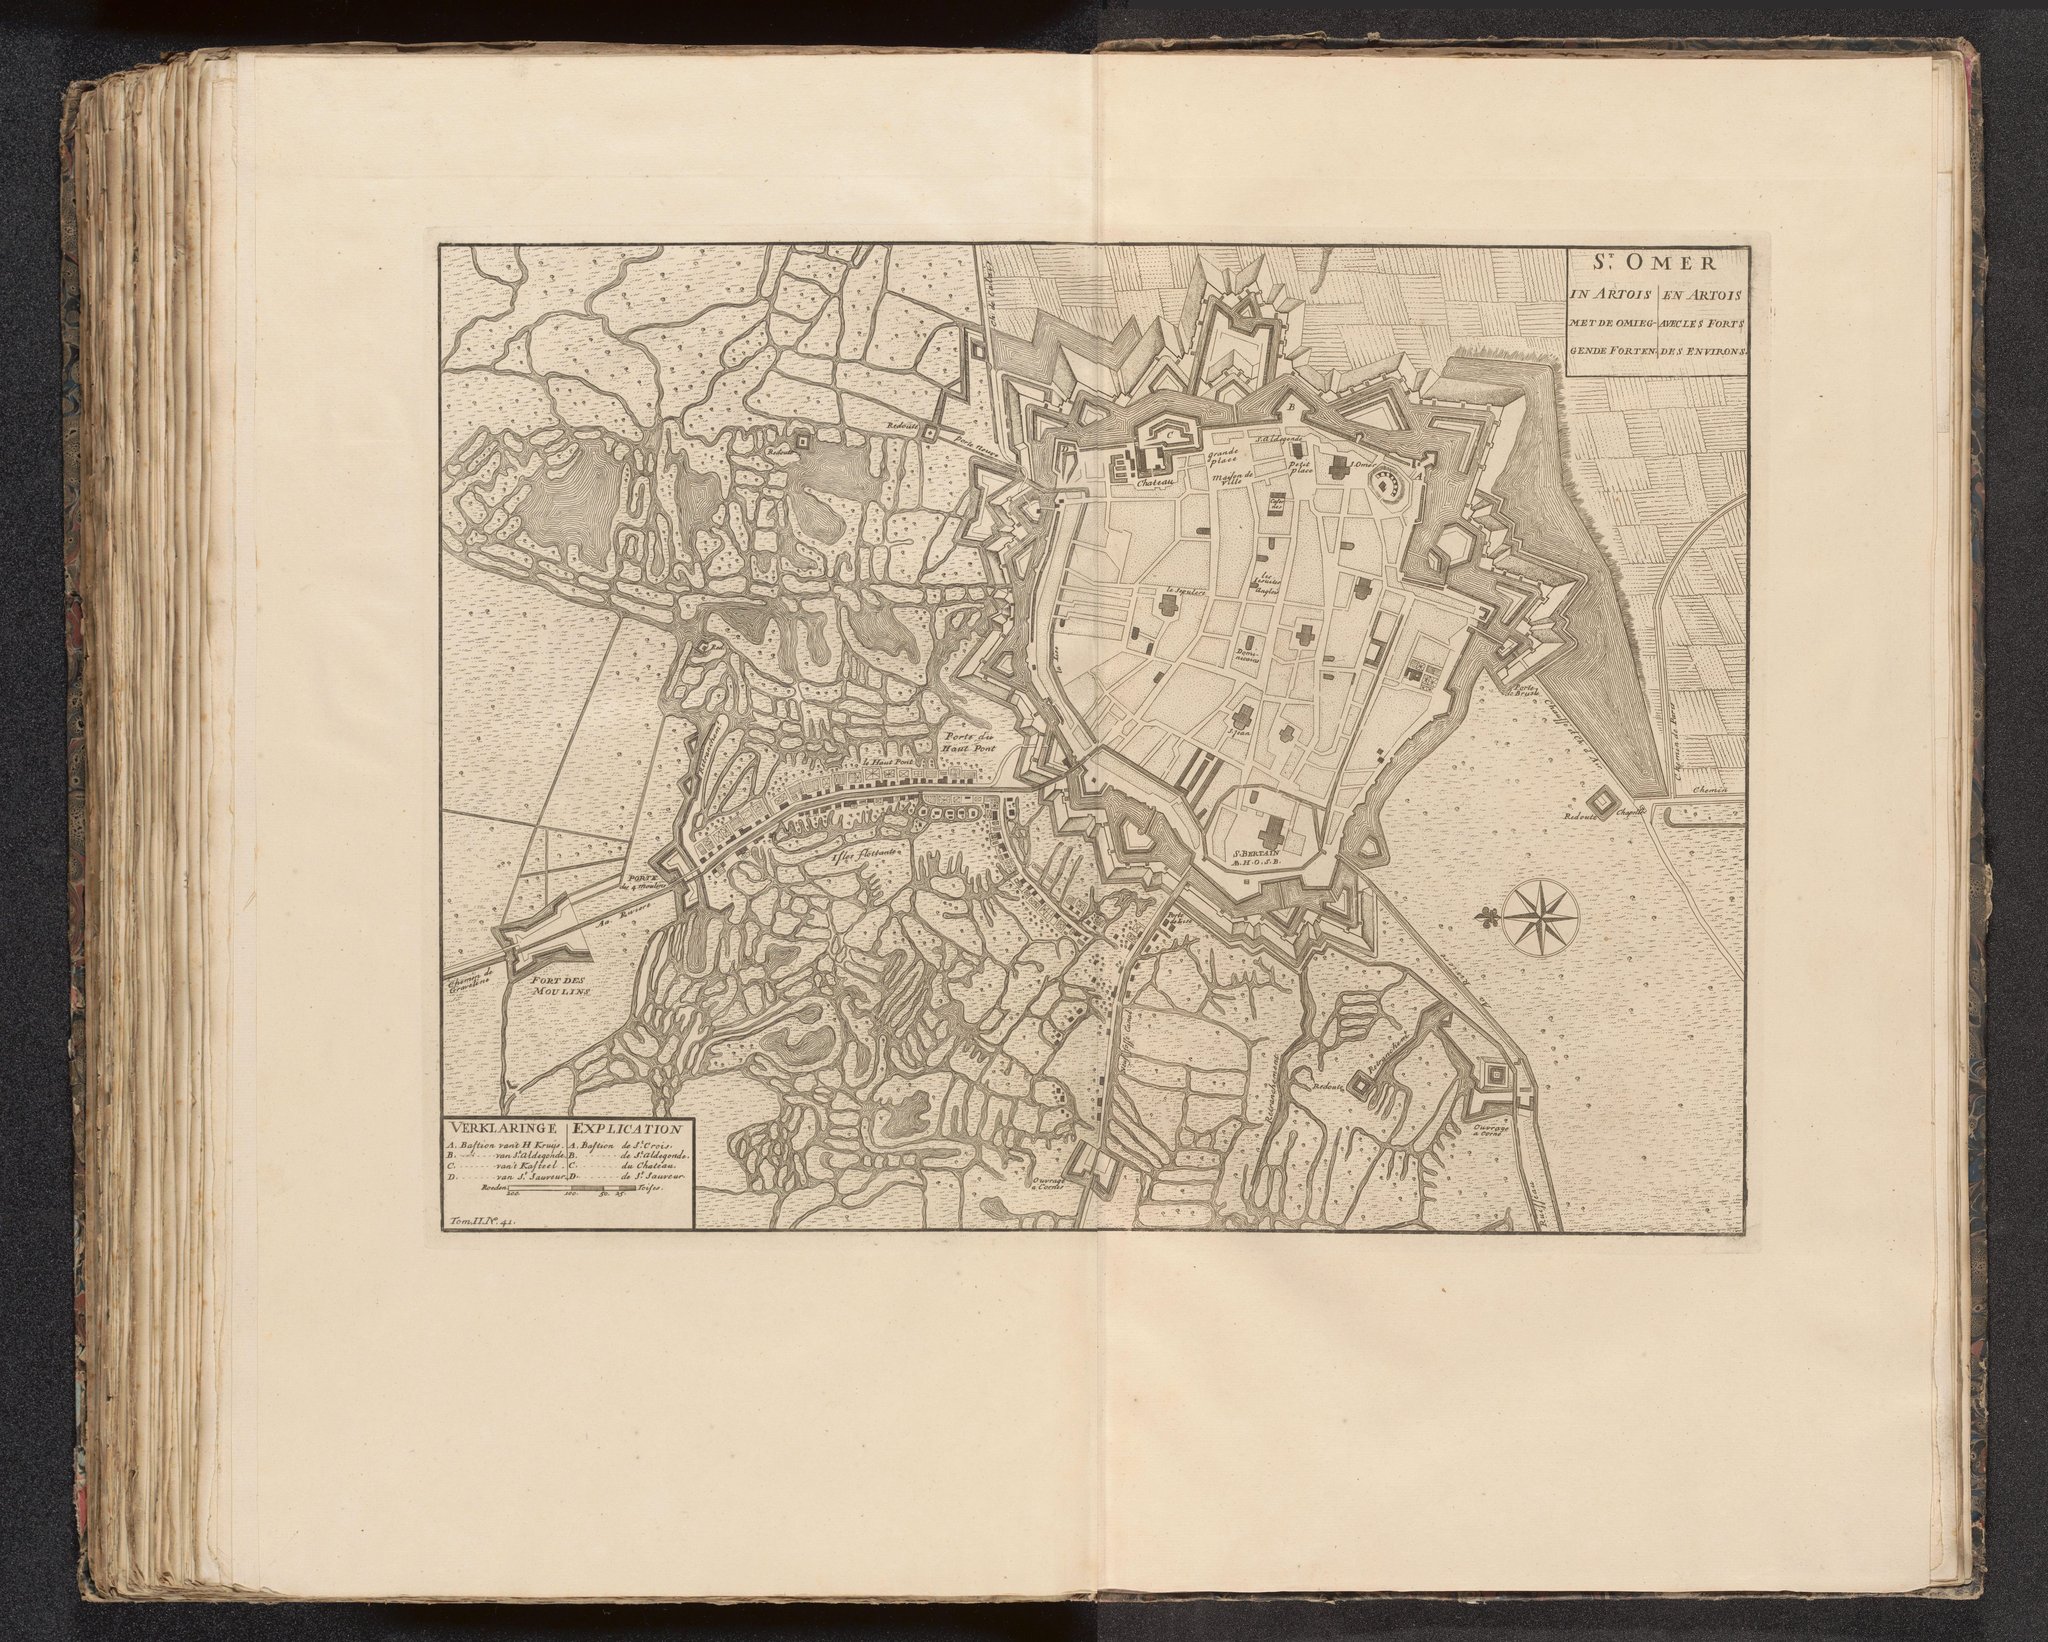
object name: print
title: St. Omer in Artois met de omleggend forten / [St. Omer] en Artois avec les forts des environs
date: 1711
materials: paper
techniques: etching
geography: the hague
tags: johan willem friso (prins van oranje-nassau), john churchill (1e hertog van marlborough), maps of cities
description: Plattegrond van de versterkingen om de stad Saint-Omer en de nabij gelegen forten, ca. 1711. Genummerd rechtsonder: Tom. II. No. 41. Illustratie in het tweede deel van : [Jean] du Mont, Oorlogskundige beschryving van de veldslagen en belegeringen, der drie ... wydvermaarde krygsoversten... den Prins Eugenius van Savoye, den ... Hertog van Marlborough, en den Prins van Oranje en Nassau-Vriesland, in de editie van 1729. Dit tweede deel is hoofdzakelijk gewijd aan de daden van de hertog van Marlborough en prins Johan Willem Friso.